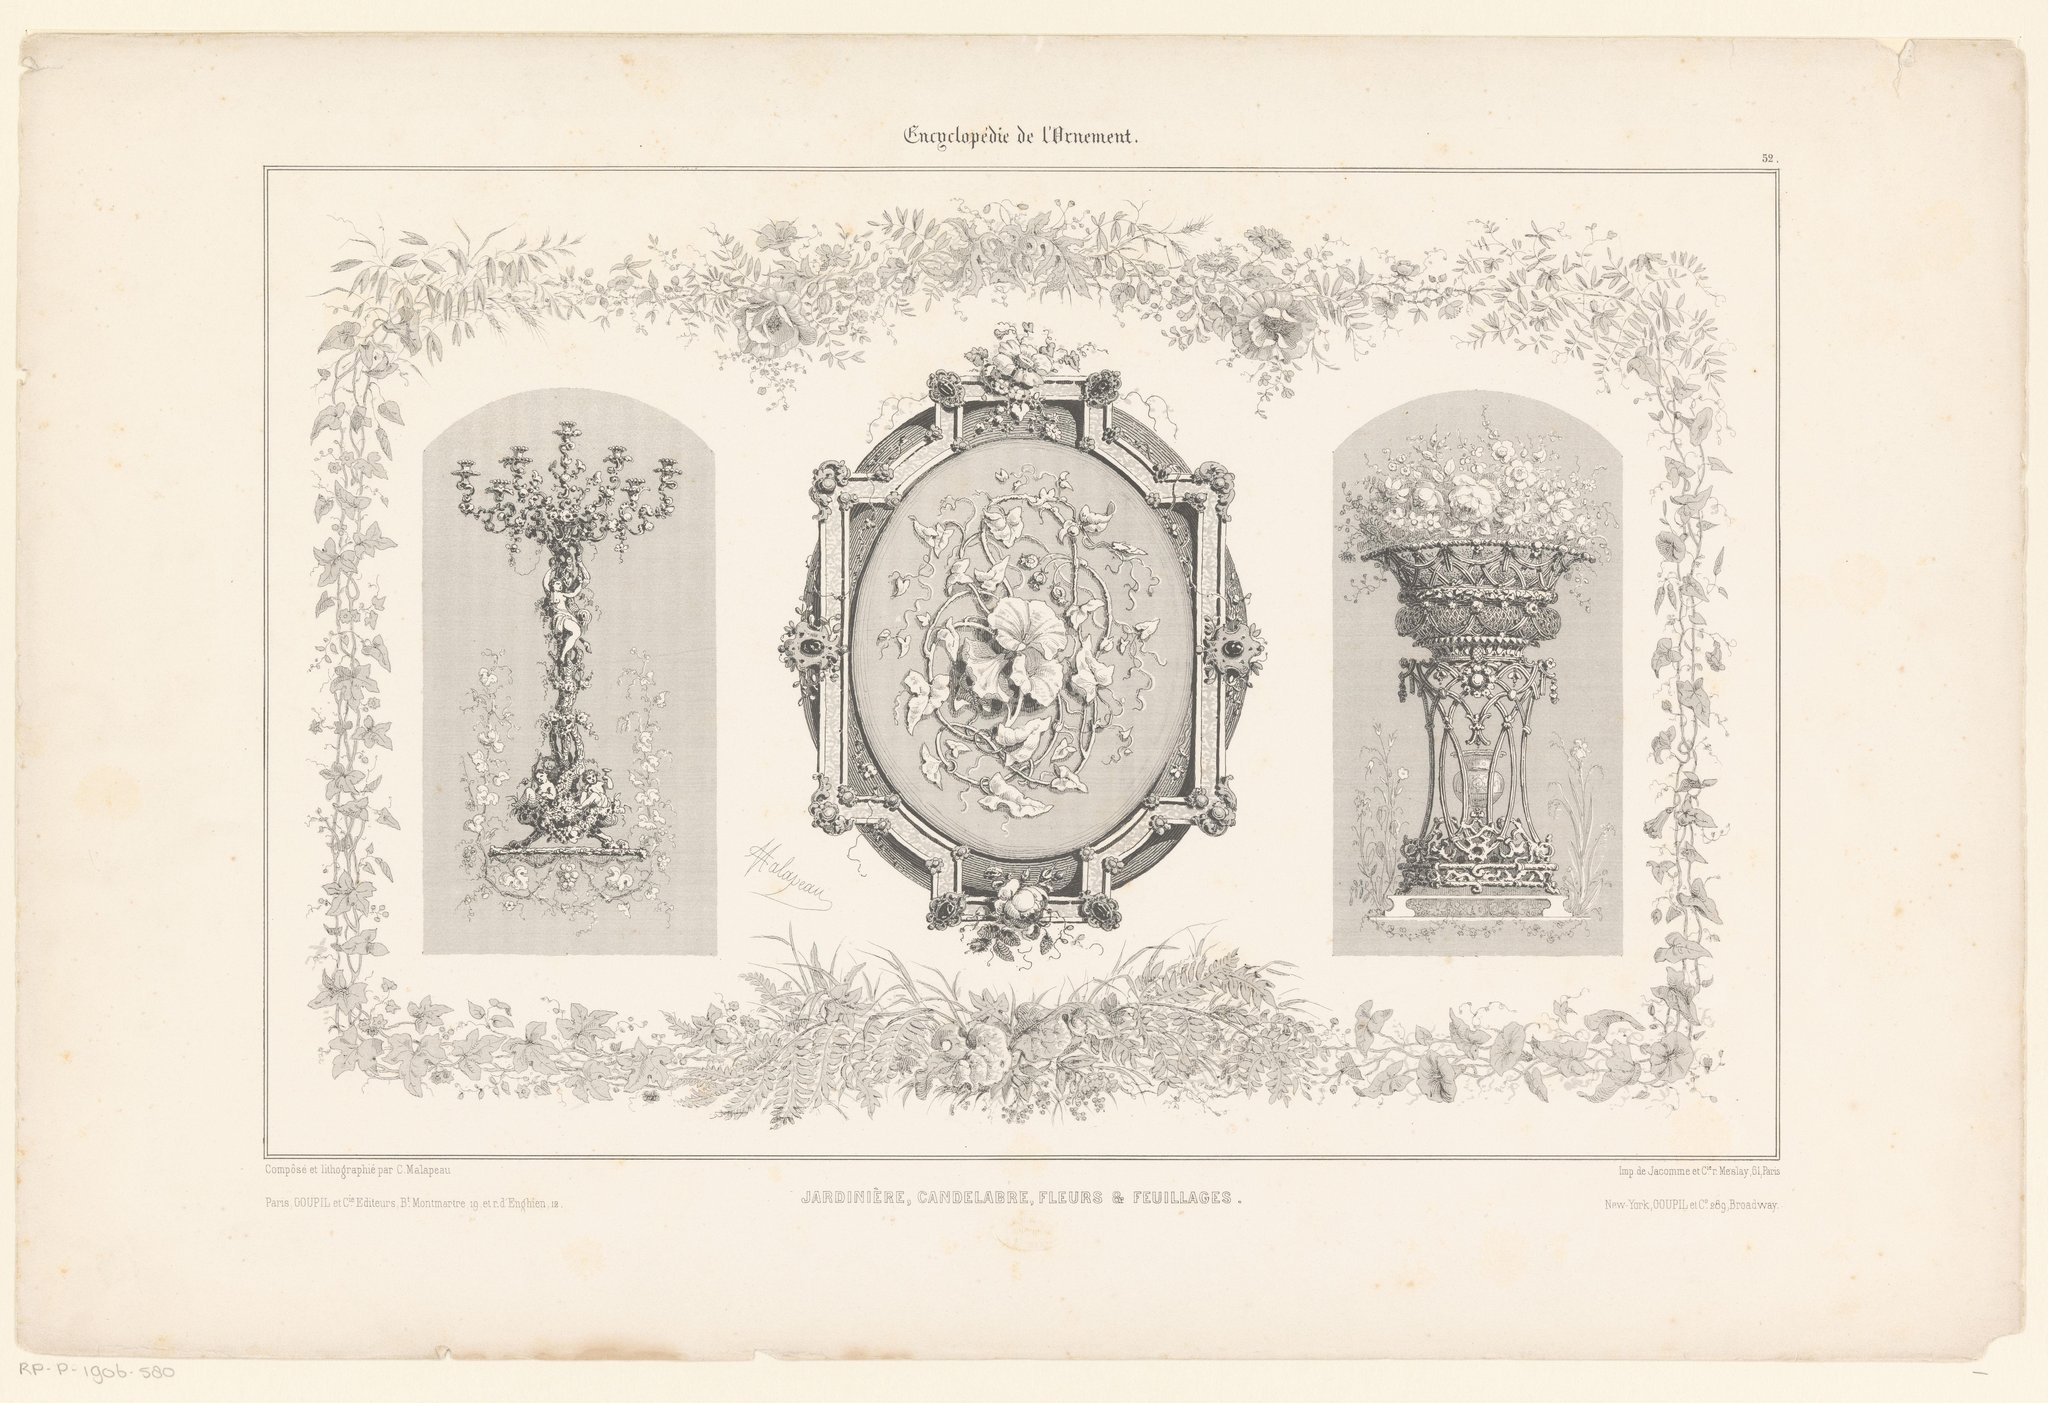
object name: print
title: Jardinère, Candelabre, Fleurs & Feuillages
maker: claude nicolas malapeau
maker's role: print maker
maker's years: 1755-1803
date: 1850-1860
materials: paper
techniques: lithograph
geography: paris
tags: flowers, chandelier, candelabrum, container made of plant material other than wood: basket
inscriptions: collector's mark: Lugt 2228, check stamp: ‘Goupil, Vibert & C / Editeurs / A Paris’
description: Links een kandelaber met een vrouw en putti. In het midden bloemen en ranken in een ornamentele omlijsting. Rechts een mand met bloemen op een opengewerkt voetstuk. Rondom de drie afbeeldingen een omlijstingen van ranken.